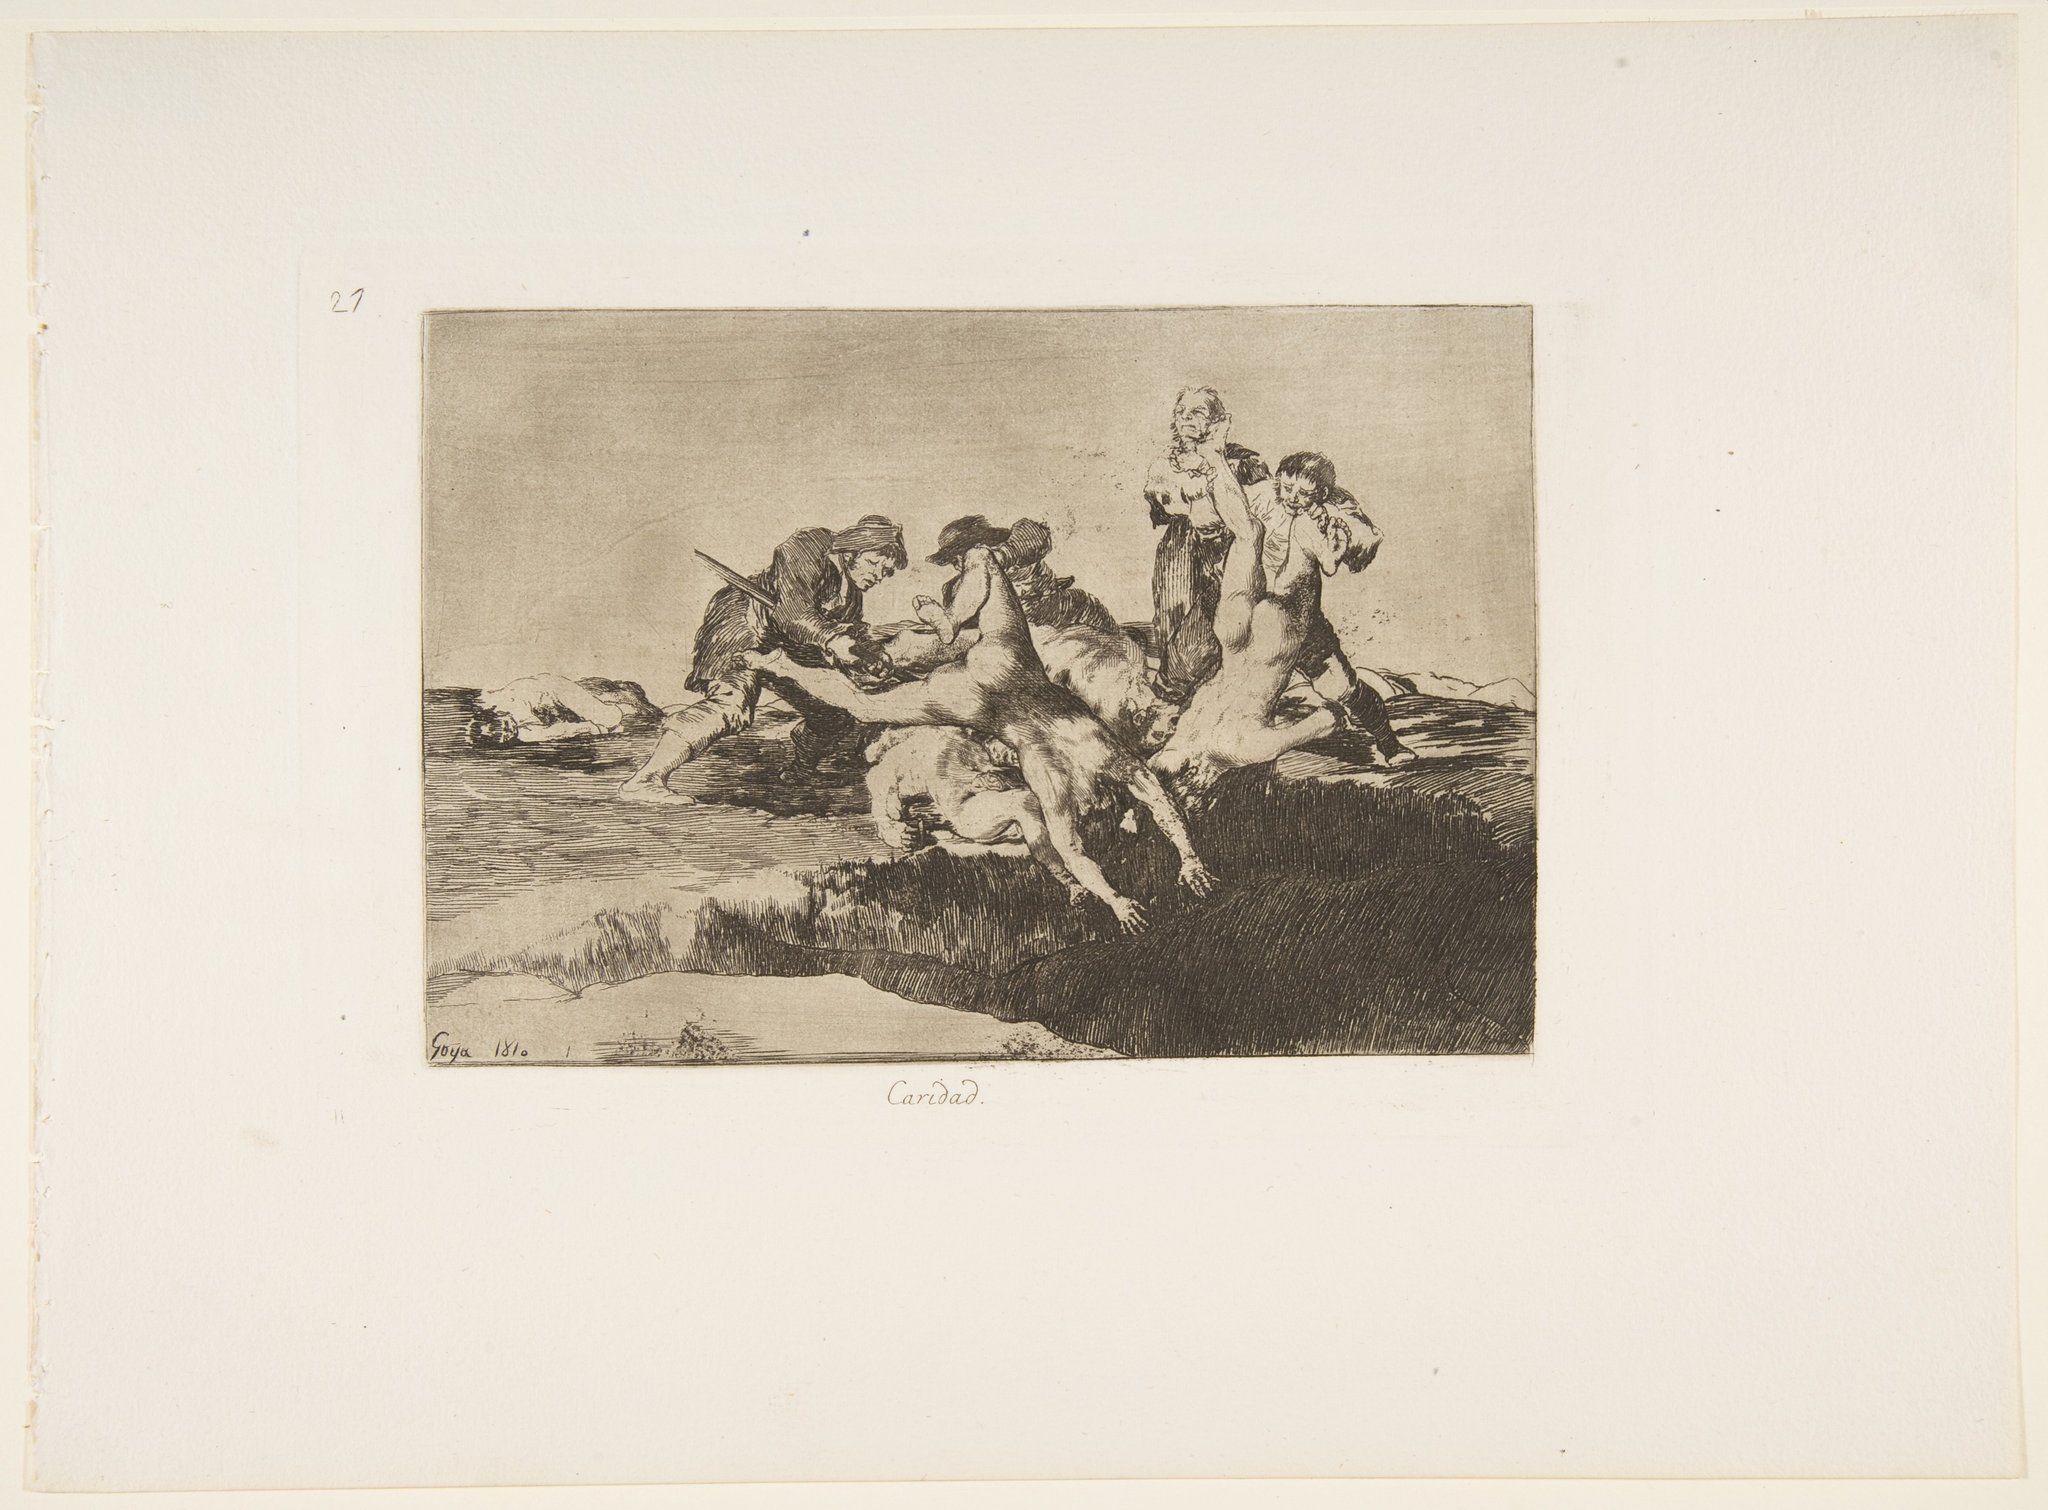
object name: print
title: Plate 27 from "The Disasters of War" (Los Desastres de la Guerra): 'Charity' (Caridad)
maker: goya (francisco de goya y lucientes)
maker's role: artist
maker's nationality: spanish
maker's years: 1746-1828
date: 1810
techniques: engraving, drypoint, etching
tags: wars,swords,suffering,men,women